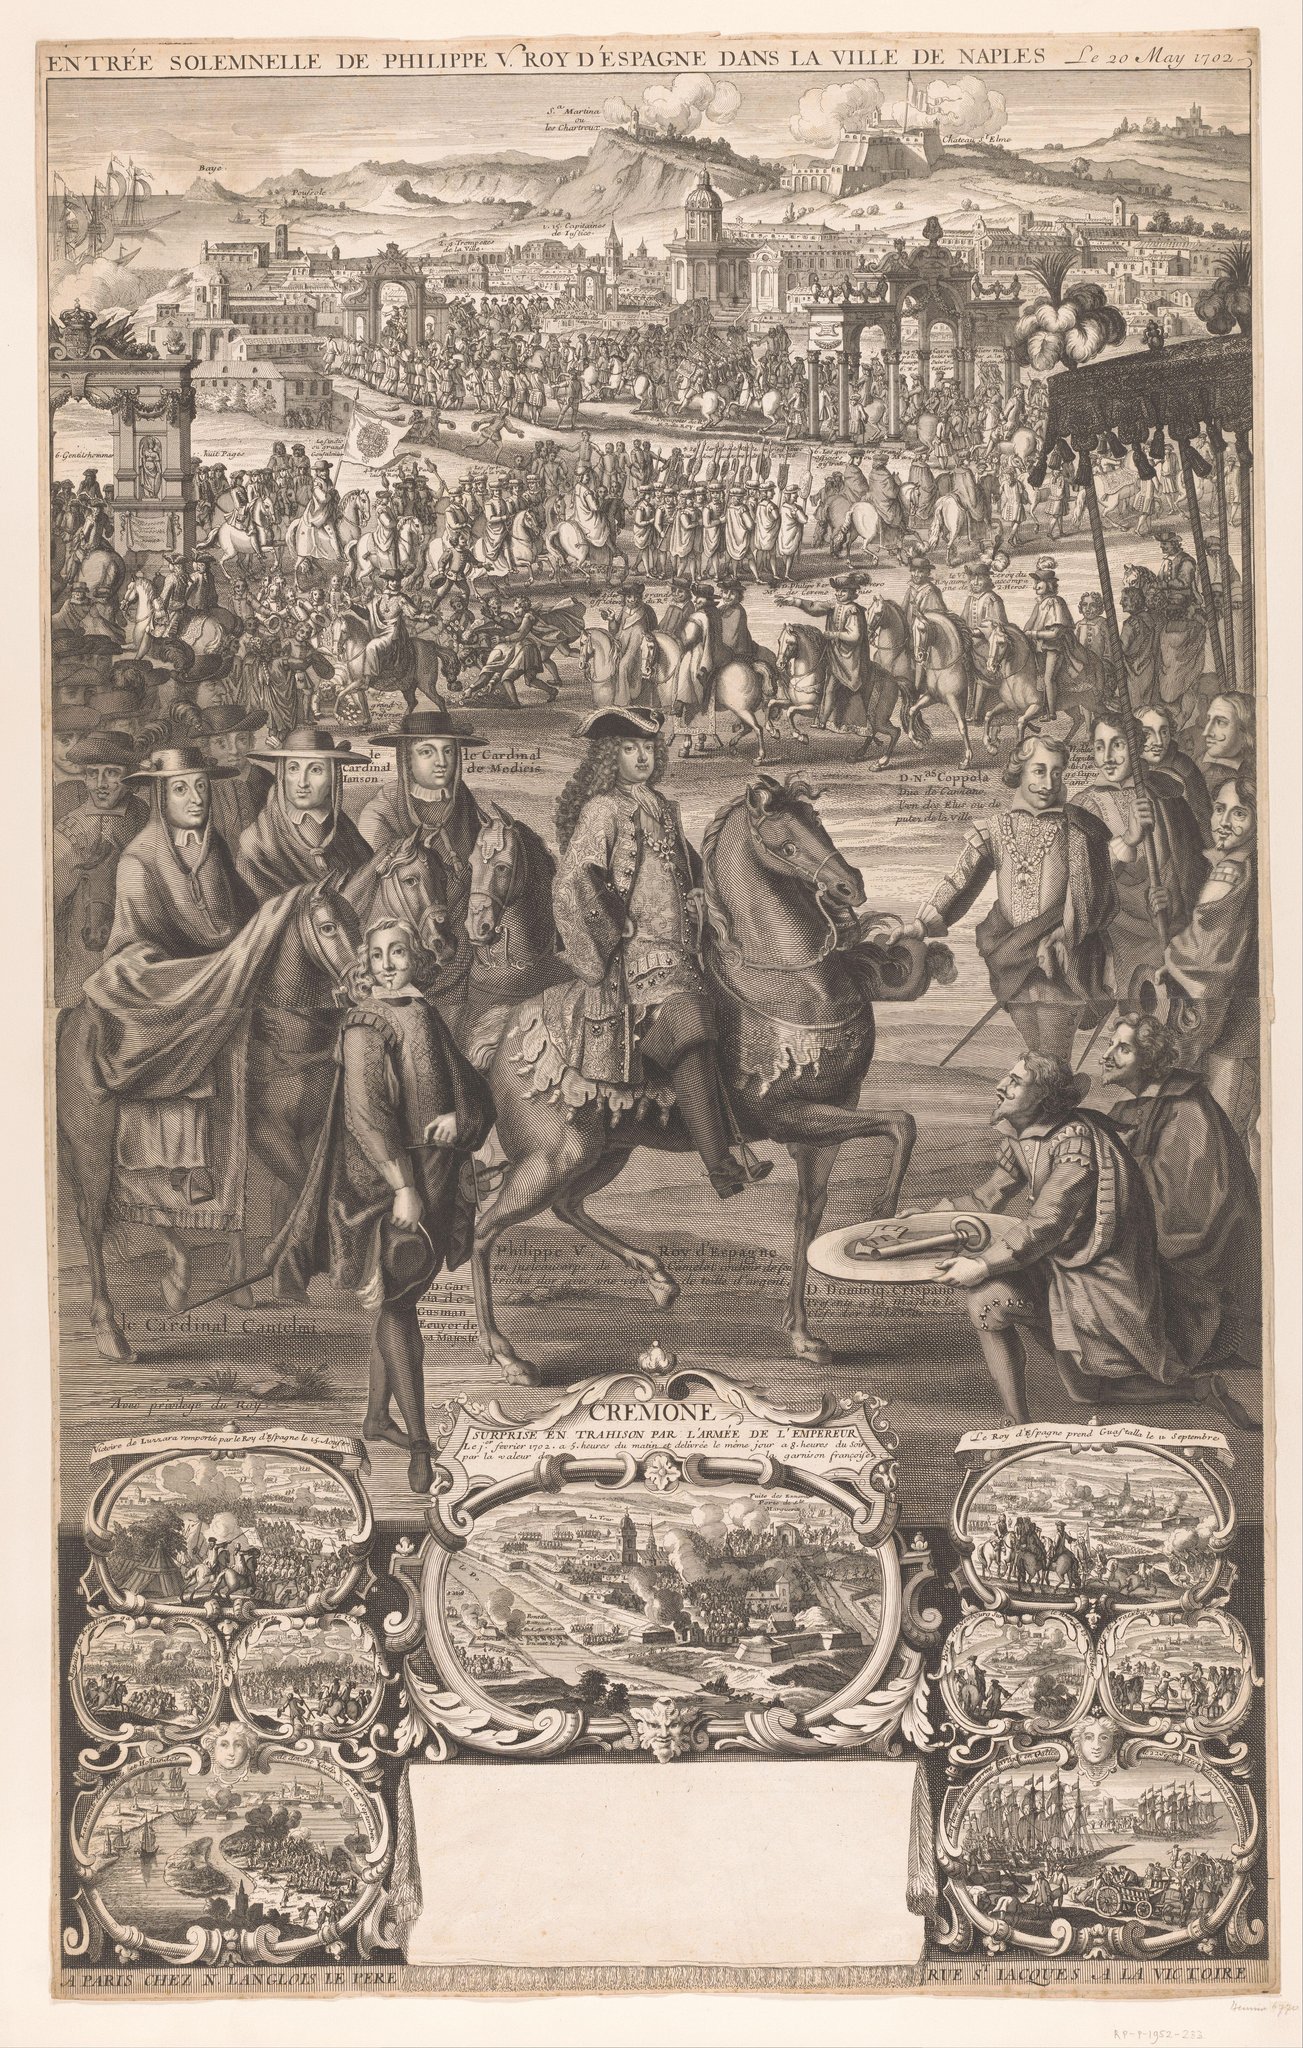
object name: print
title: Entrée solemnelle de Philippe V. Roy d'Espagne dans la ville de Naples Le 20 May 1702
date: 1702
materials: paper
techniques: engraving, etching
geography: paris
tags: filips v (koning van spanje), public festivities on the occasion of royal events, triumphal entry and public reception, pageant, 'entrée solennelle', 'joyeuse entrée', naples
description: Plechtige intocht van Filips V van Spanje te Naples, 20 Mei 1702. De koning te paard ontvangt de sleutels van de stad, verderop gaat de stoet met de koning gaat door een triomfboog de stad binnen. Onderaan kleinere scènes uit de Spaanse Successieoorlog.